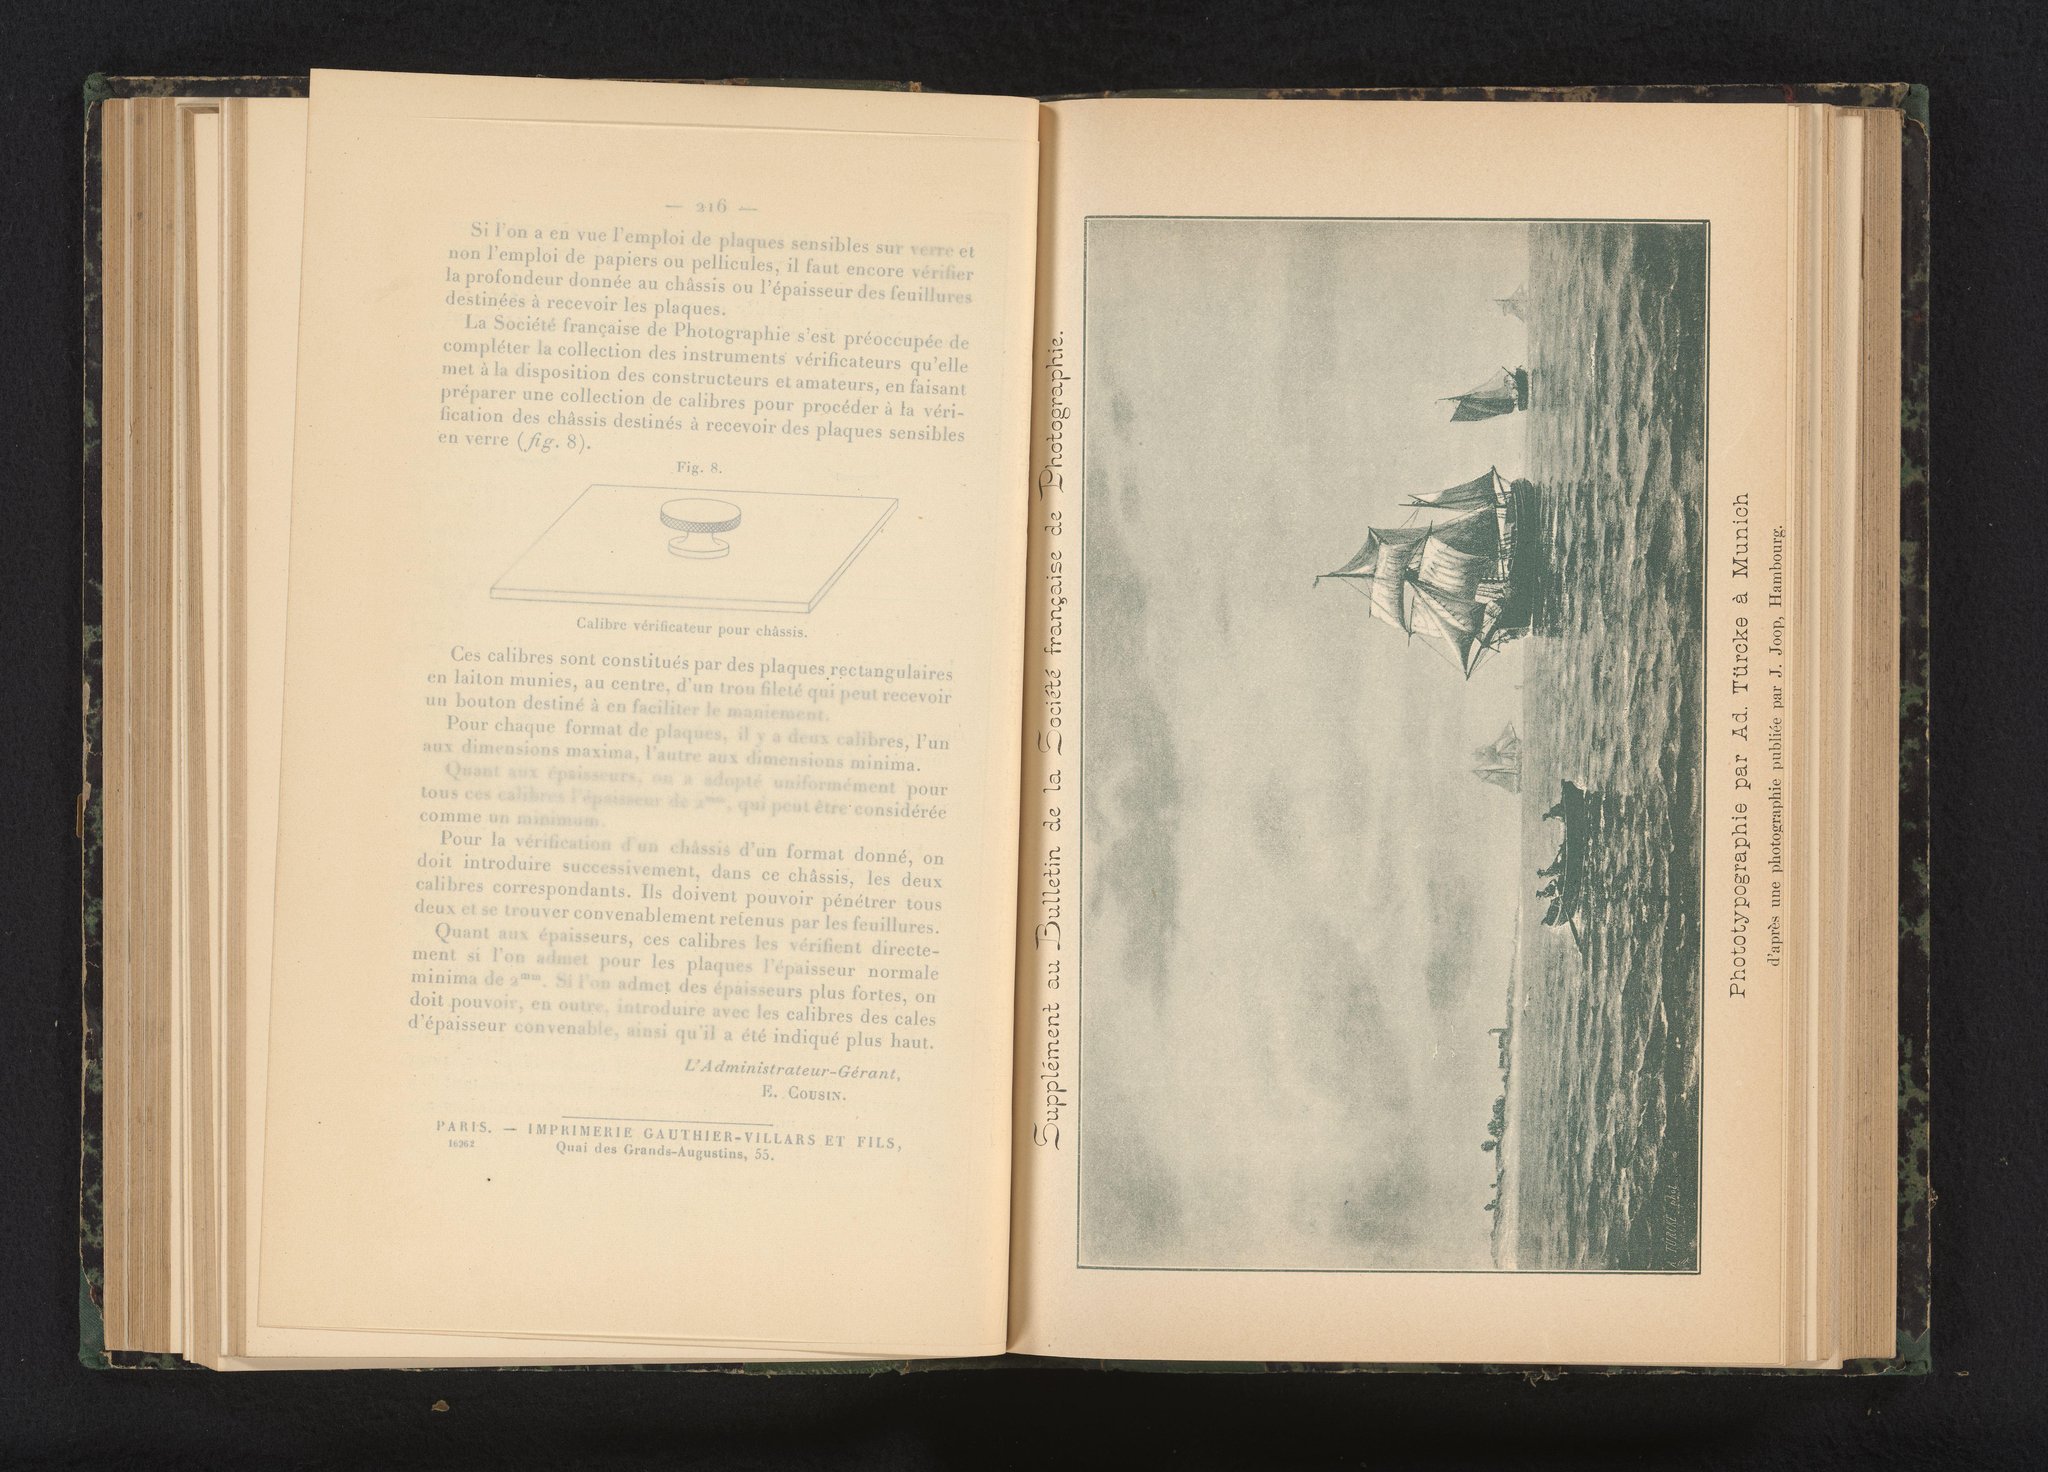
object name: page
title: Reproductie van een schilderij van een zeegezicht met schepen voor de kust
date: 1886-1891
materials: paper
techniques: autotype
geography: munich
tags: sailing-ship, sailing-boat, sea (seascape)